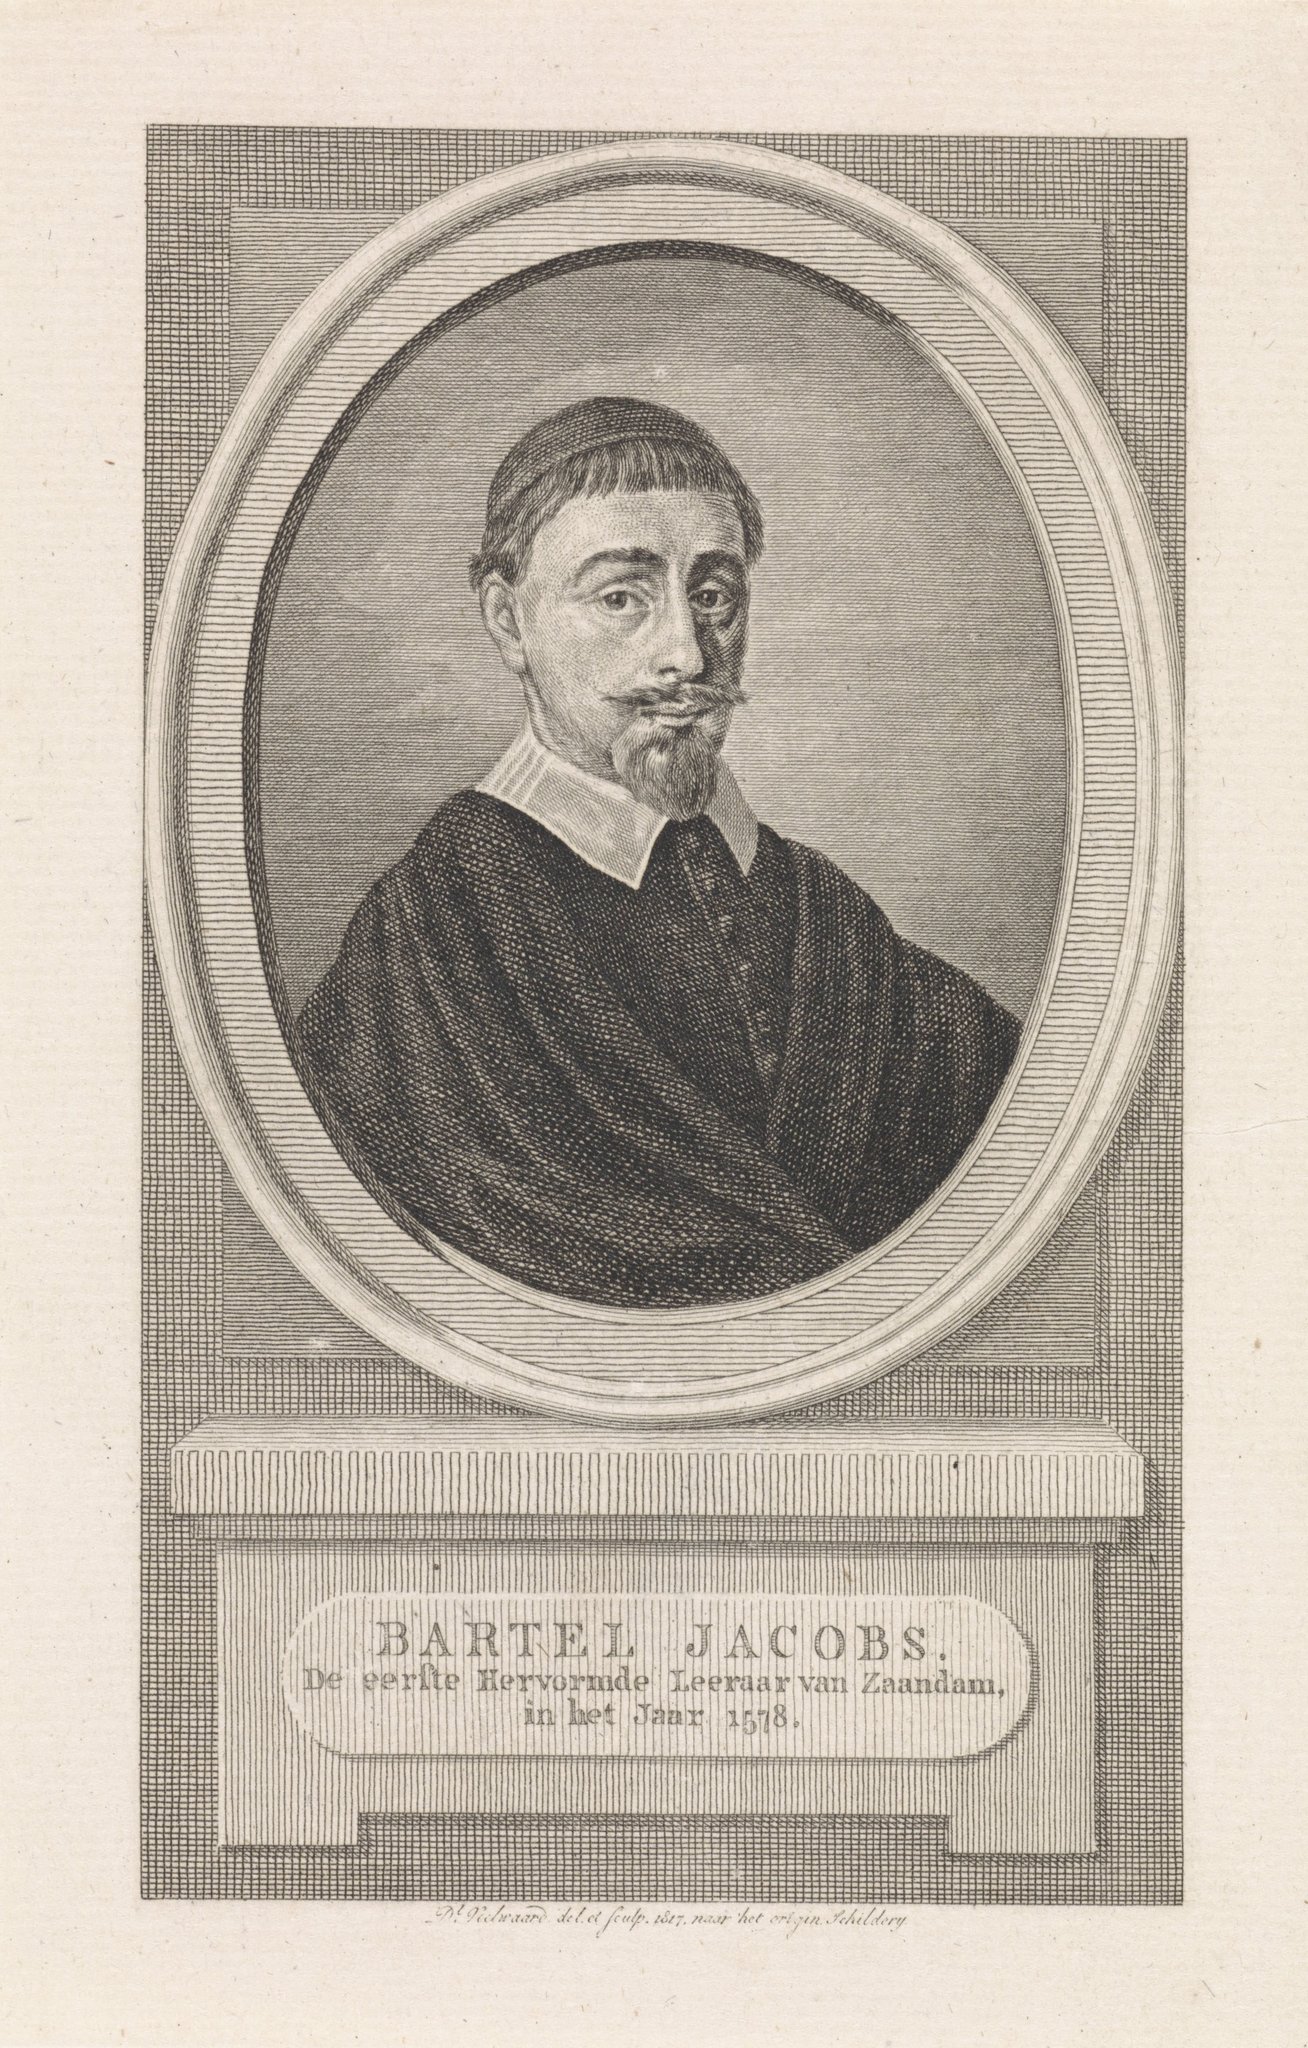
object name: print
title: Portret van de predikant Bartel Jacobsz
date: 1817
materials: paper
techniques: engraving, etching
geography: amsterdam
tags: predikant, bartel jacobsz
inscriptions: collector's mark: Lugt 2228